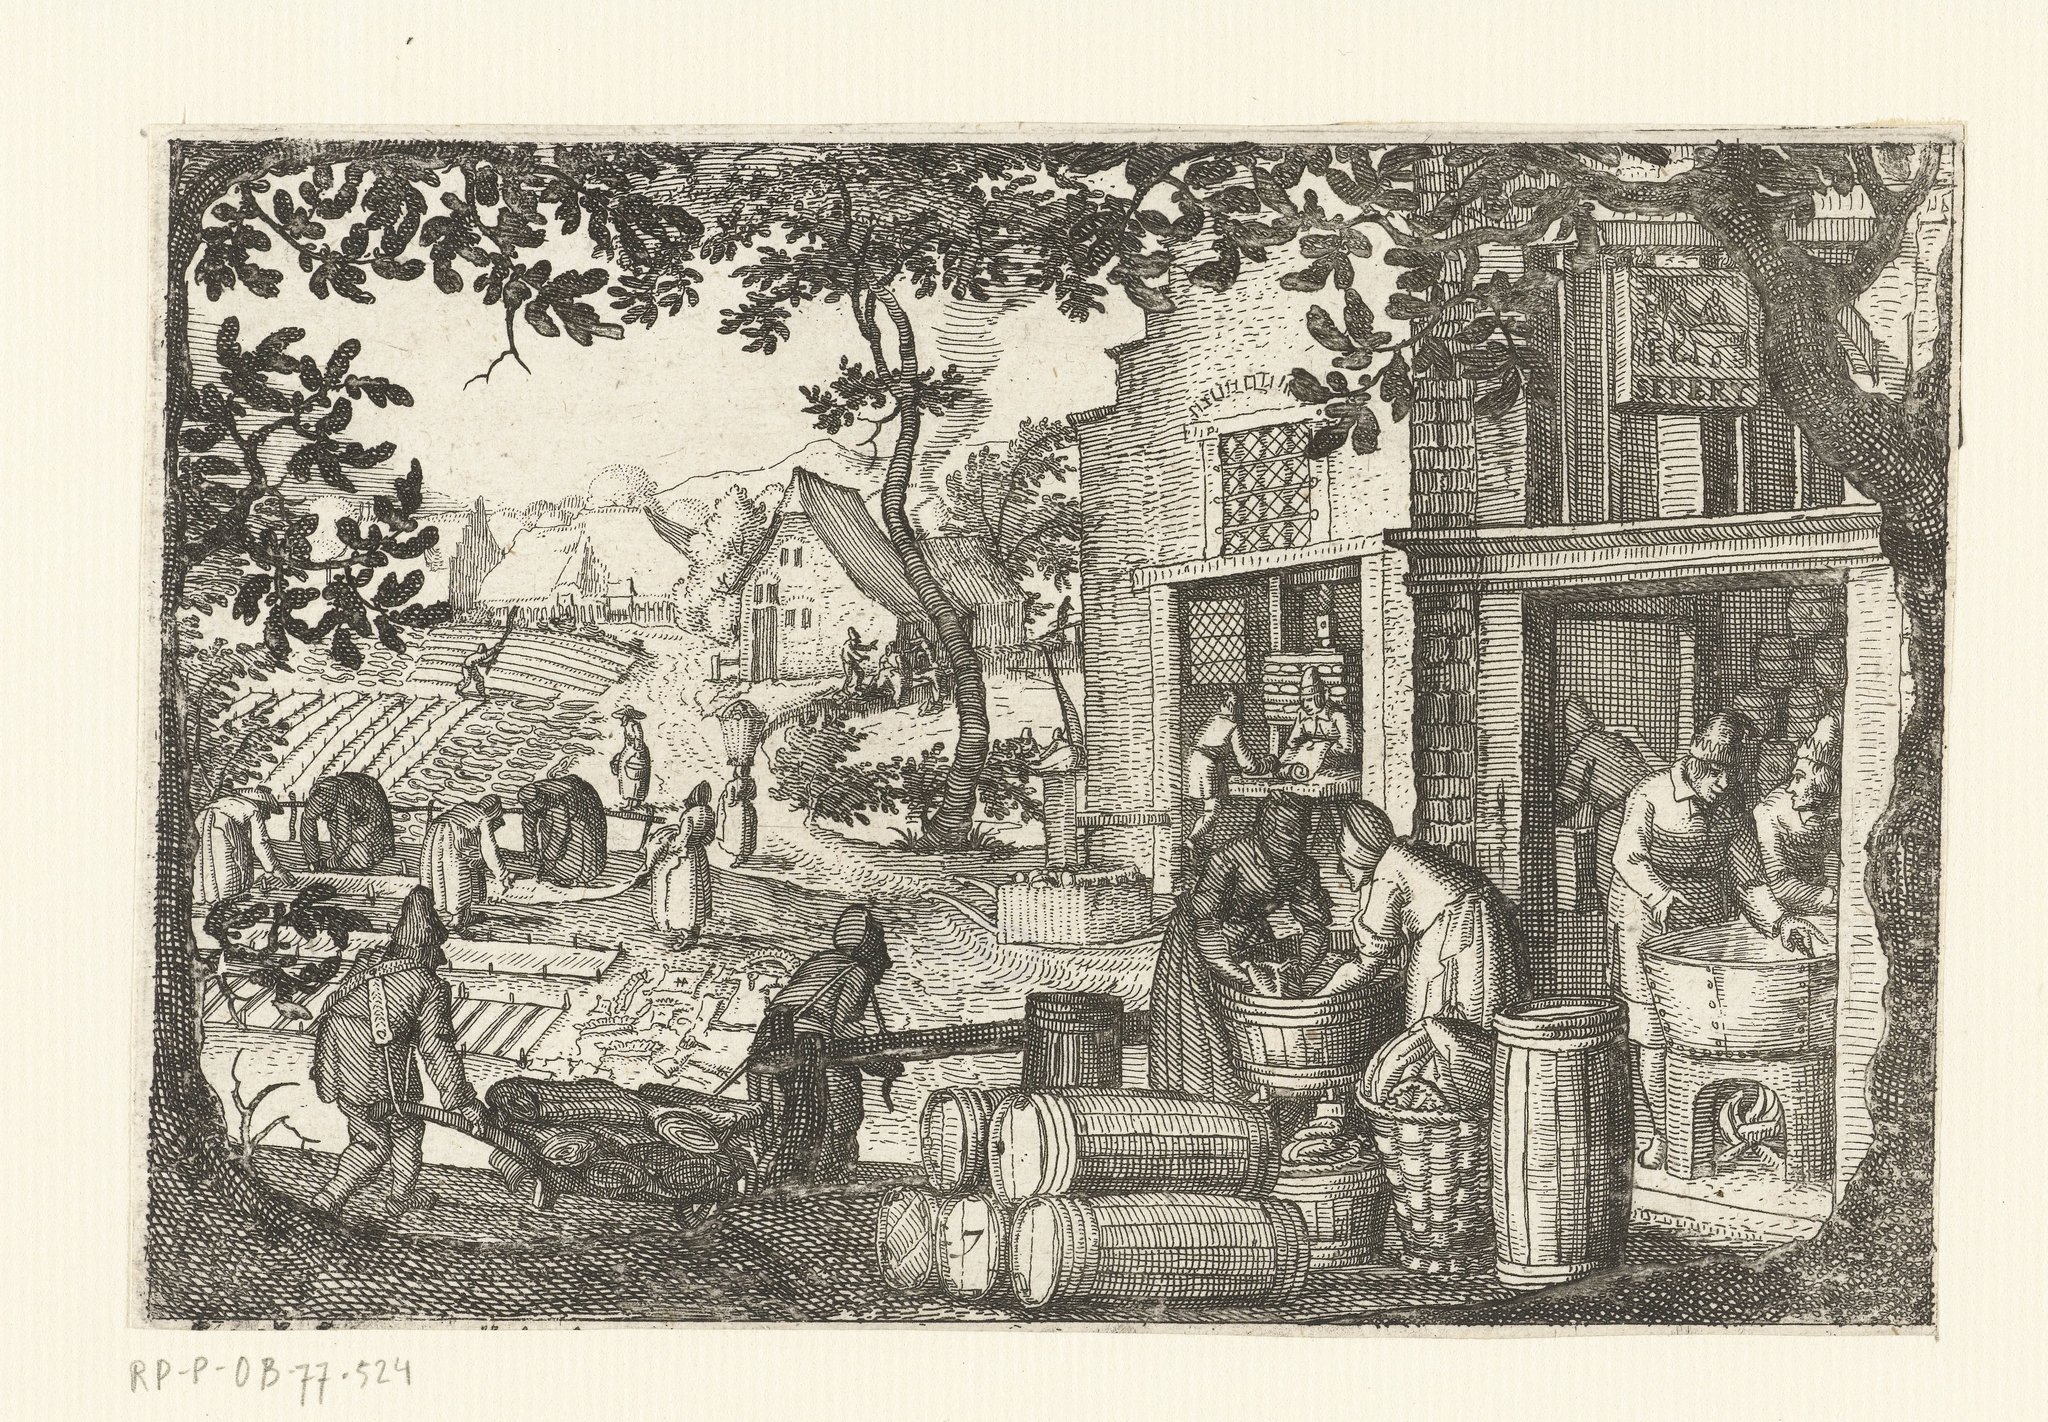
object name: print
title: Beroepen in Noord-Holland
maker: claes jansz. visscher (ii)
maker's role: draughtsman, print maker, publisher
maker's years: 1586-1652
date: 1608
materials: paper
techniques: etching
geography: northern netherlands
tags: bleaching (laundering), laundering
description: Wasserij en bleekvelden, ca. 1600. Koken en spoelen van wasgoed, op de achtergrond wordt de was op de bleekvelden te drogen en bleken gelegd. No. 7 uit serie beroepen in Noord-Holland.